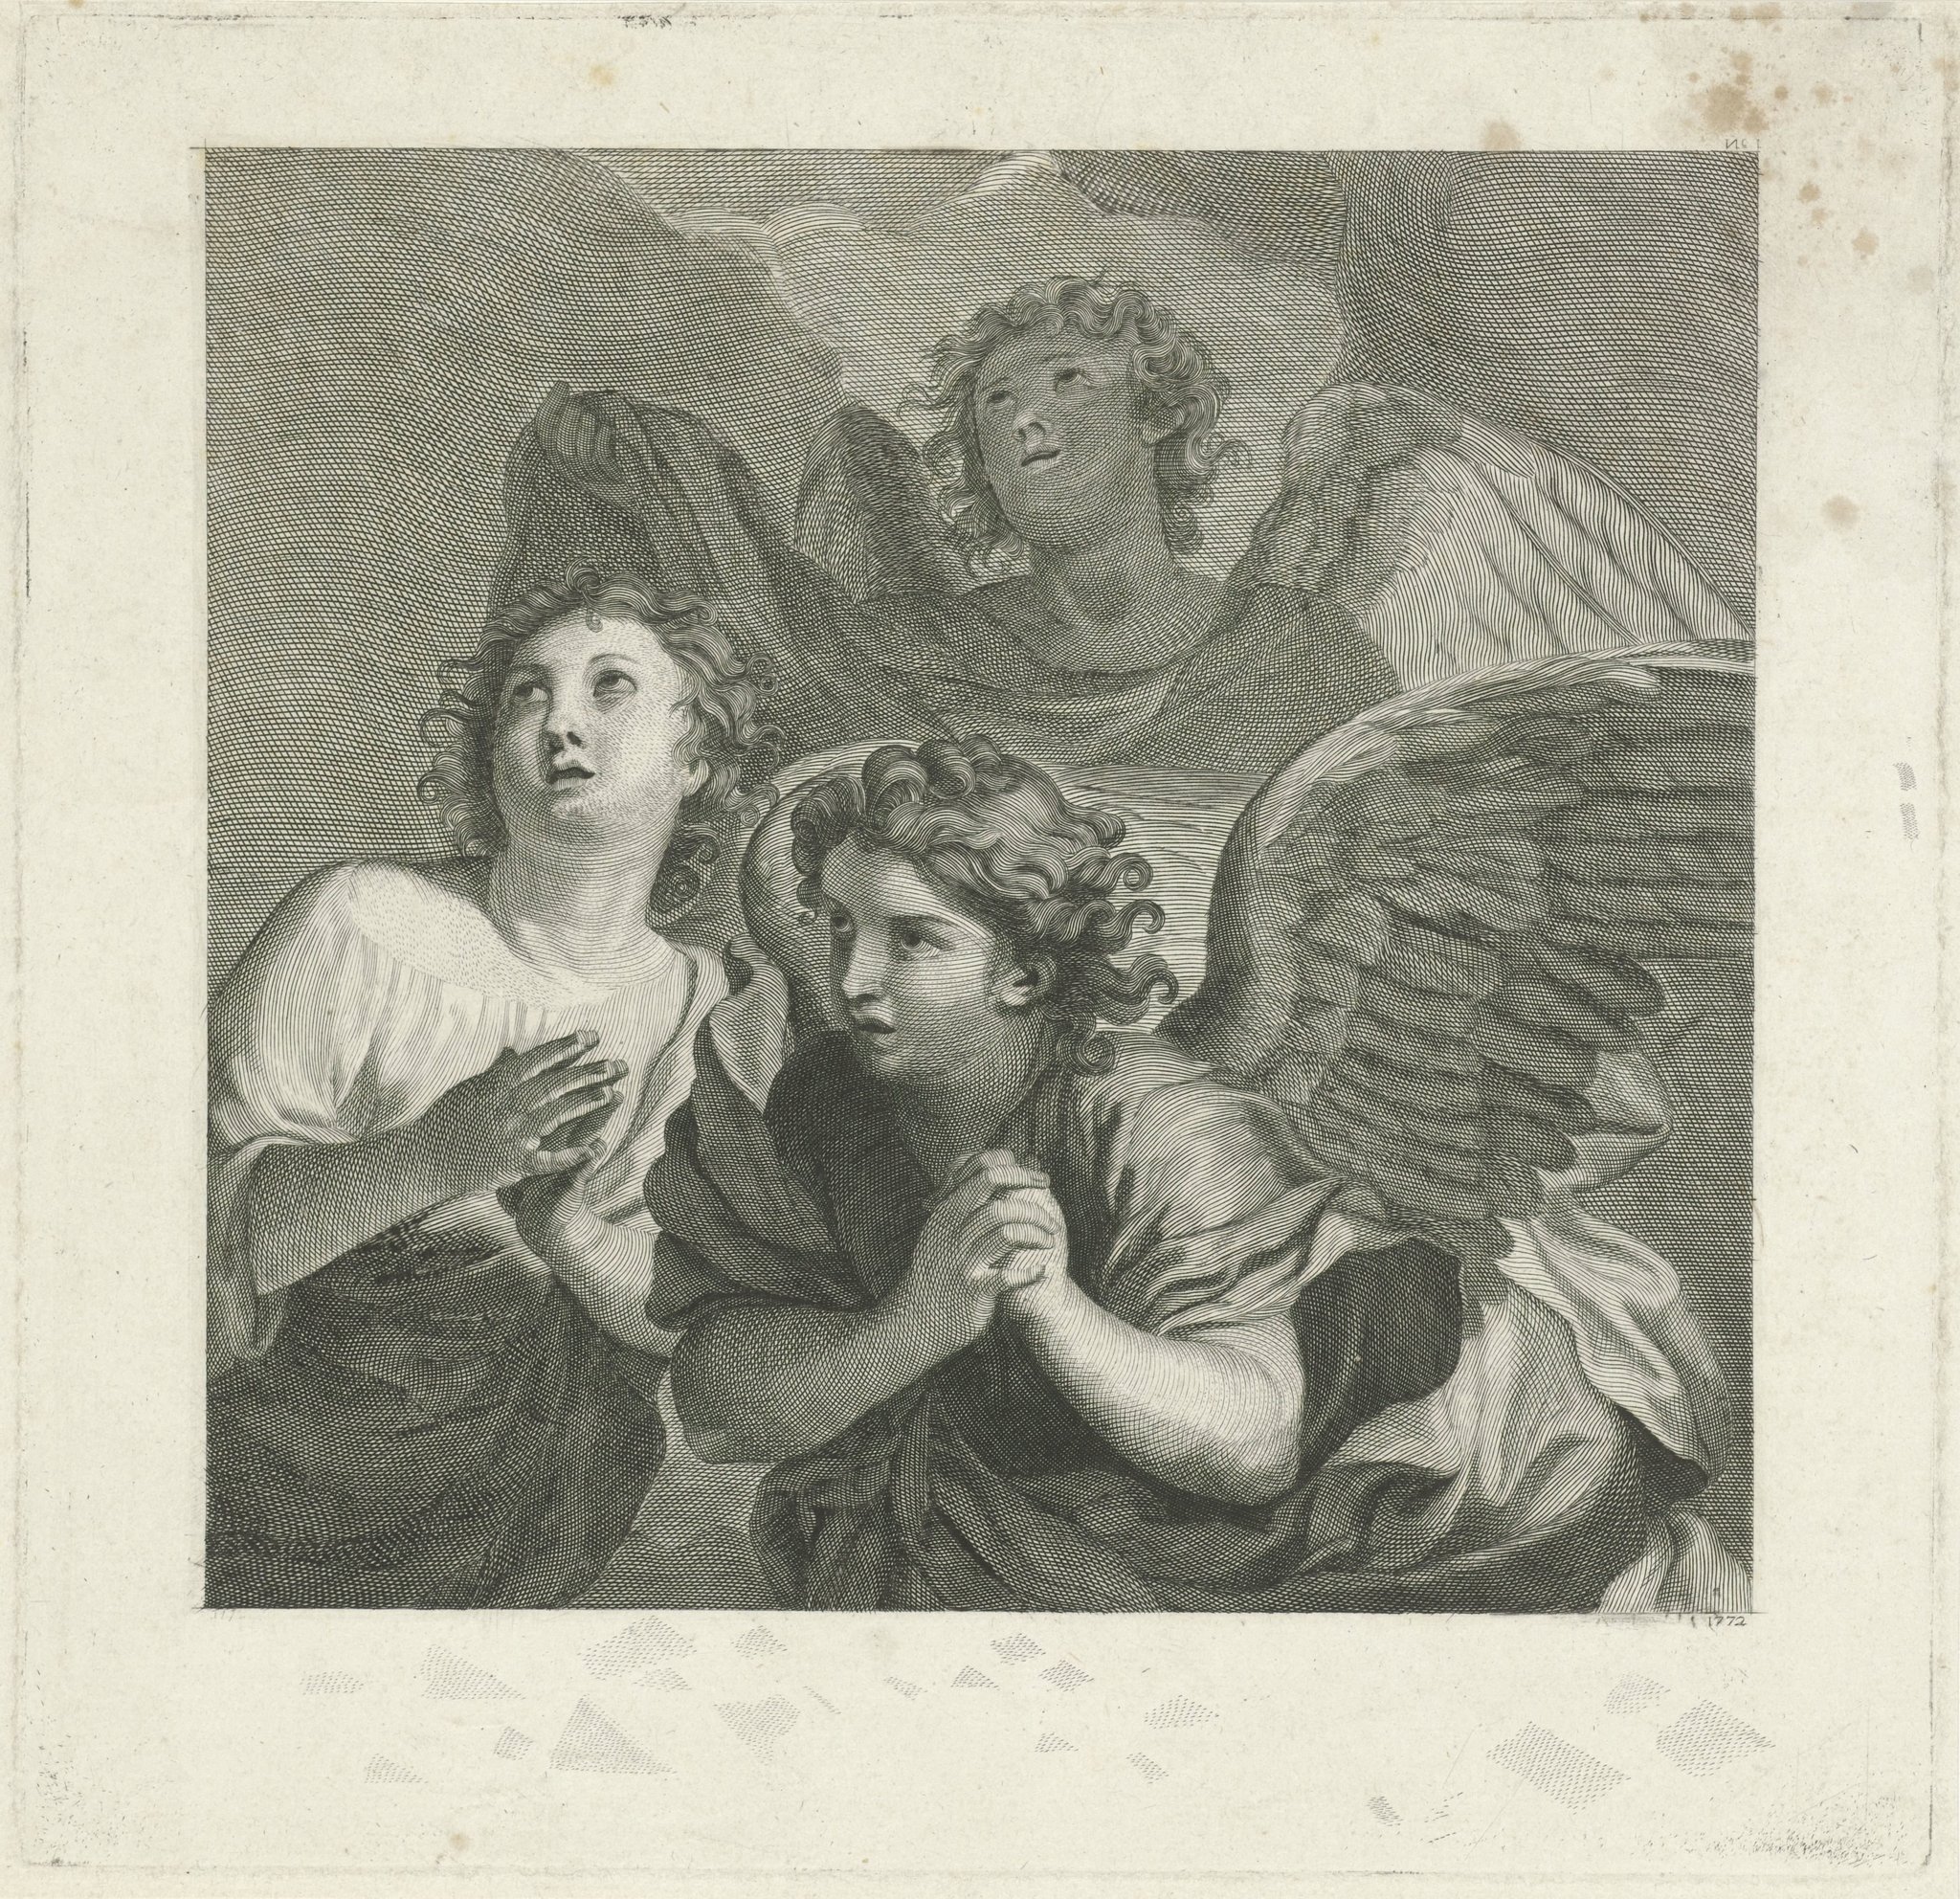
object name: print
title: Drie engelen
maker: pieter willem van megen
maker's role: print maker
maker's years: 1750-1785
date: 1772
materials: paper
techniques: engraving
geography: paris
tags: angels in adoration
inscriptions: collector's mark: Lugt 240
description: Drie aanbiddende engelen, waarvan twee de handen vouwen.